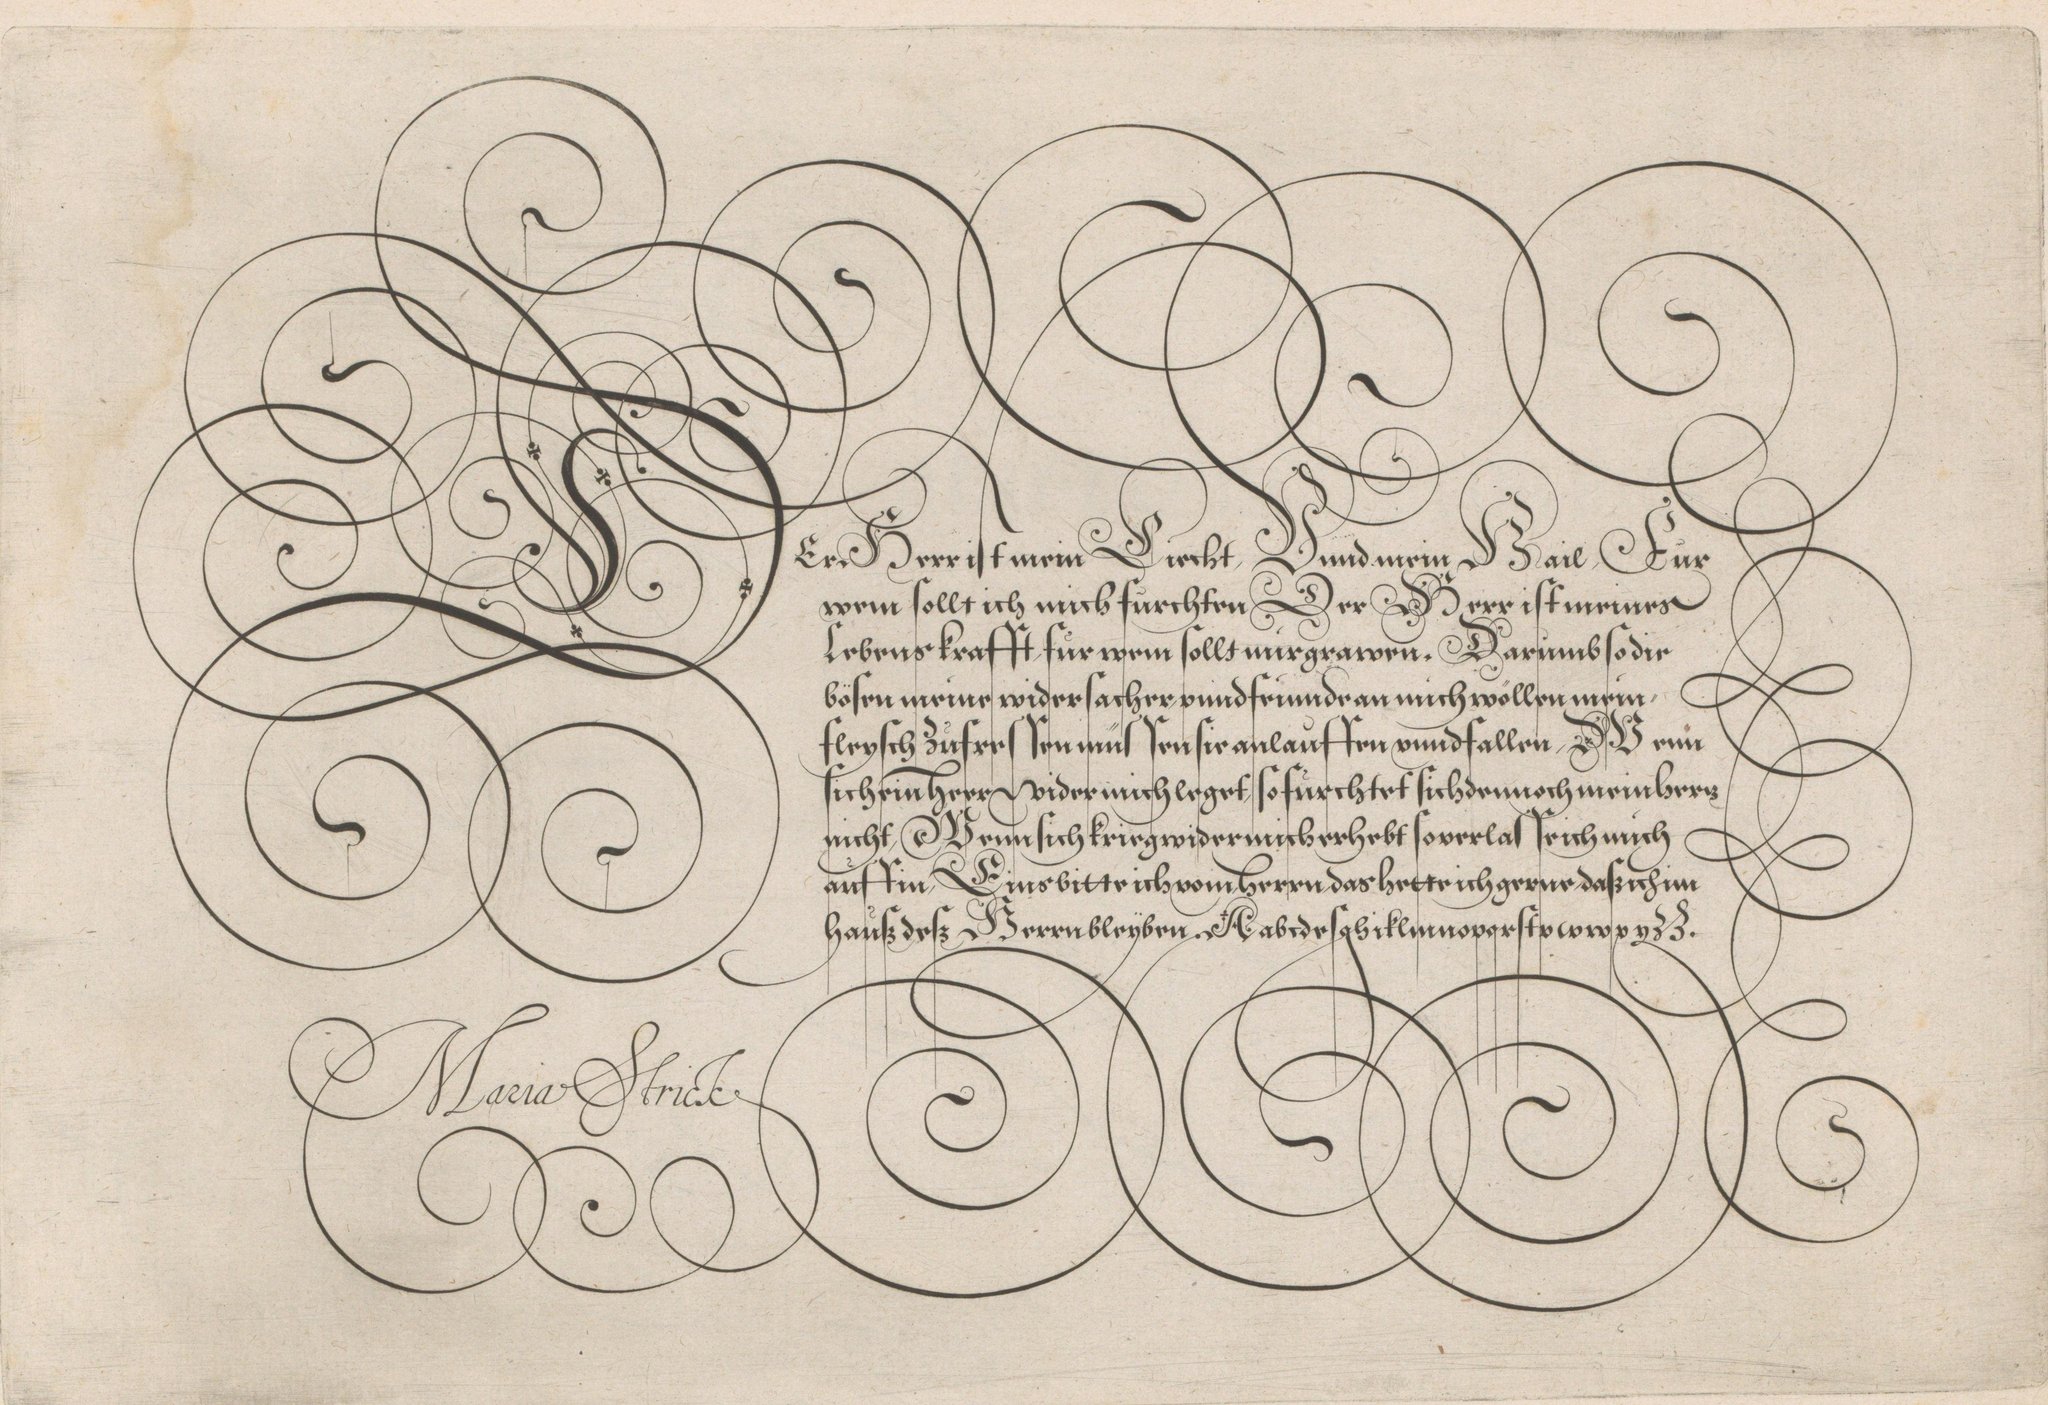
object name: print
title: Schrijfvoorbeeld met kapitaal D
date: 1618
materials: paper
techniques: engraving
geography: rotterdam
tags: calligraphy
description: Schrijfvoorbeeld in het Duits met kapitaal D en negen regels tekst: Den Herr ist mein Liecht (...). Omlijst door kalligrafisch krulwerk. De prent maakt deel uit van een album.